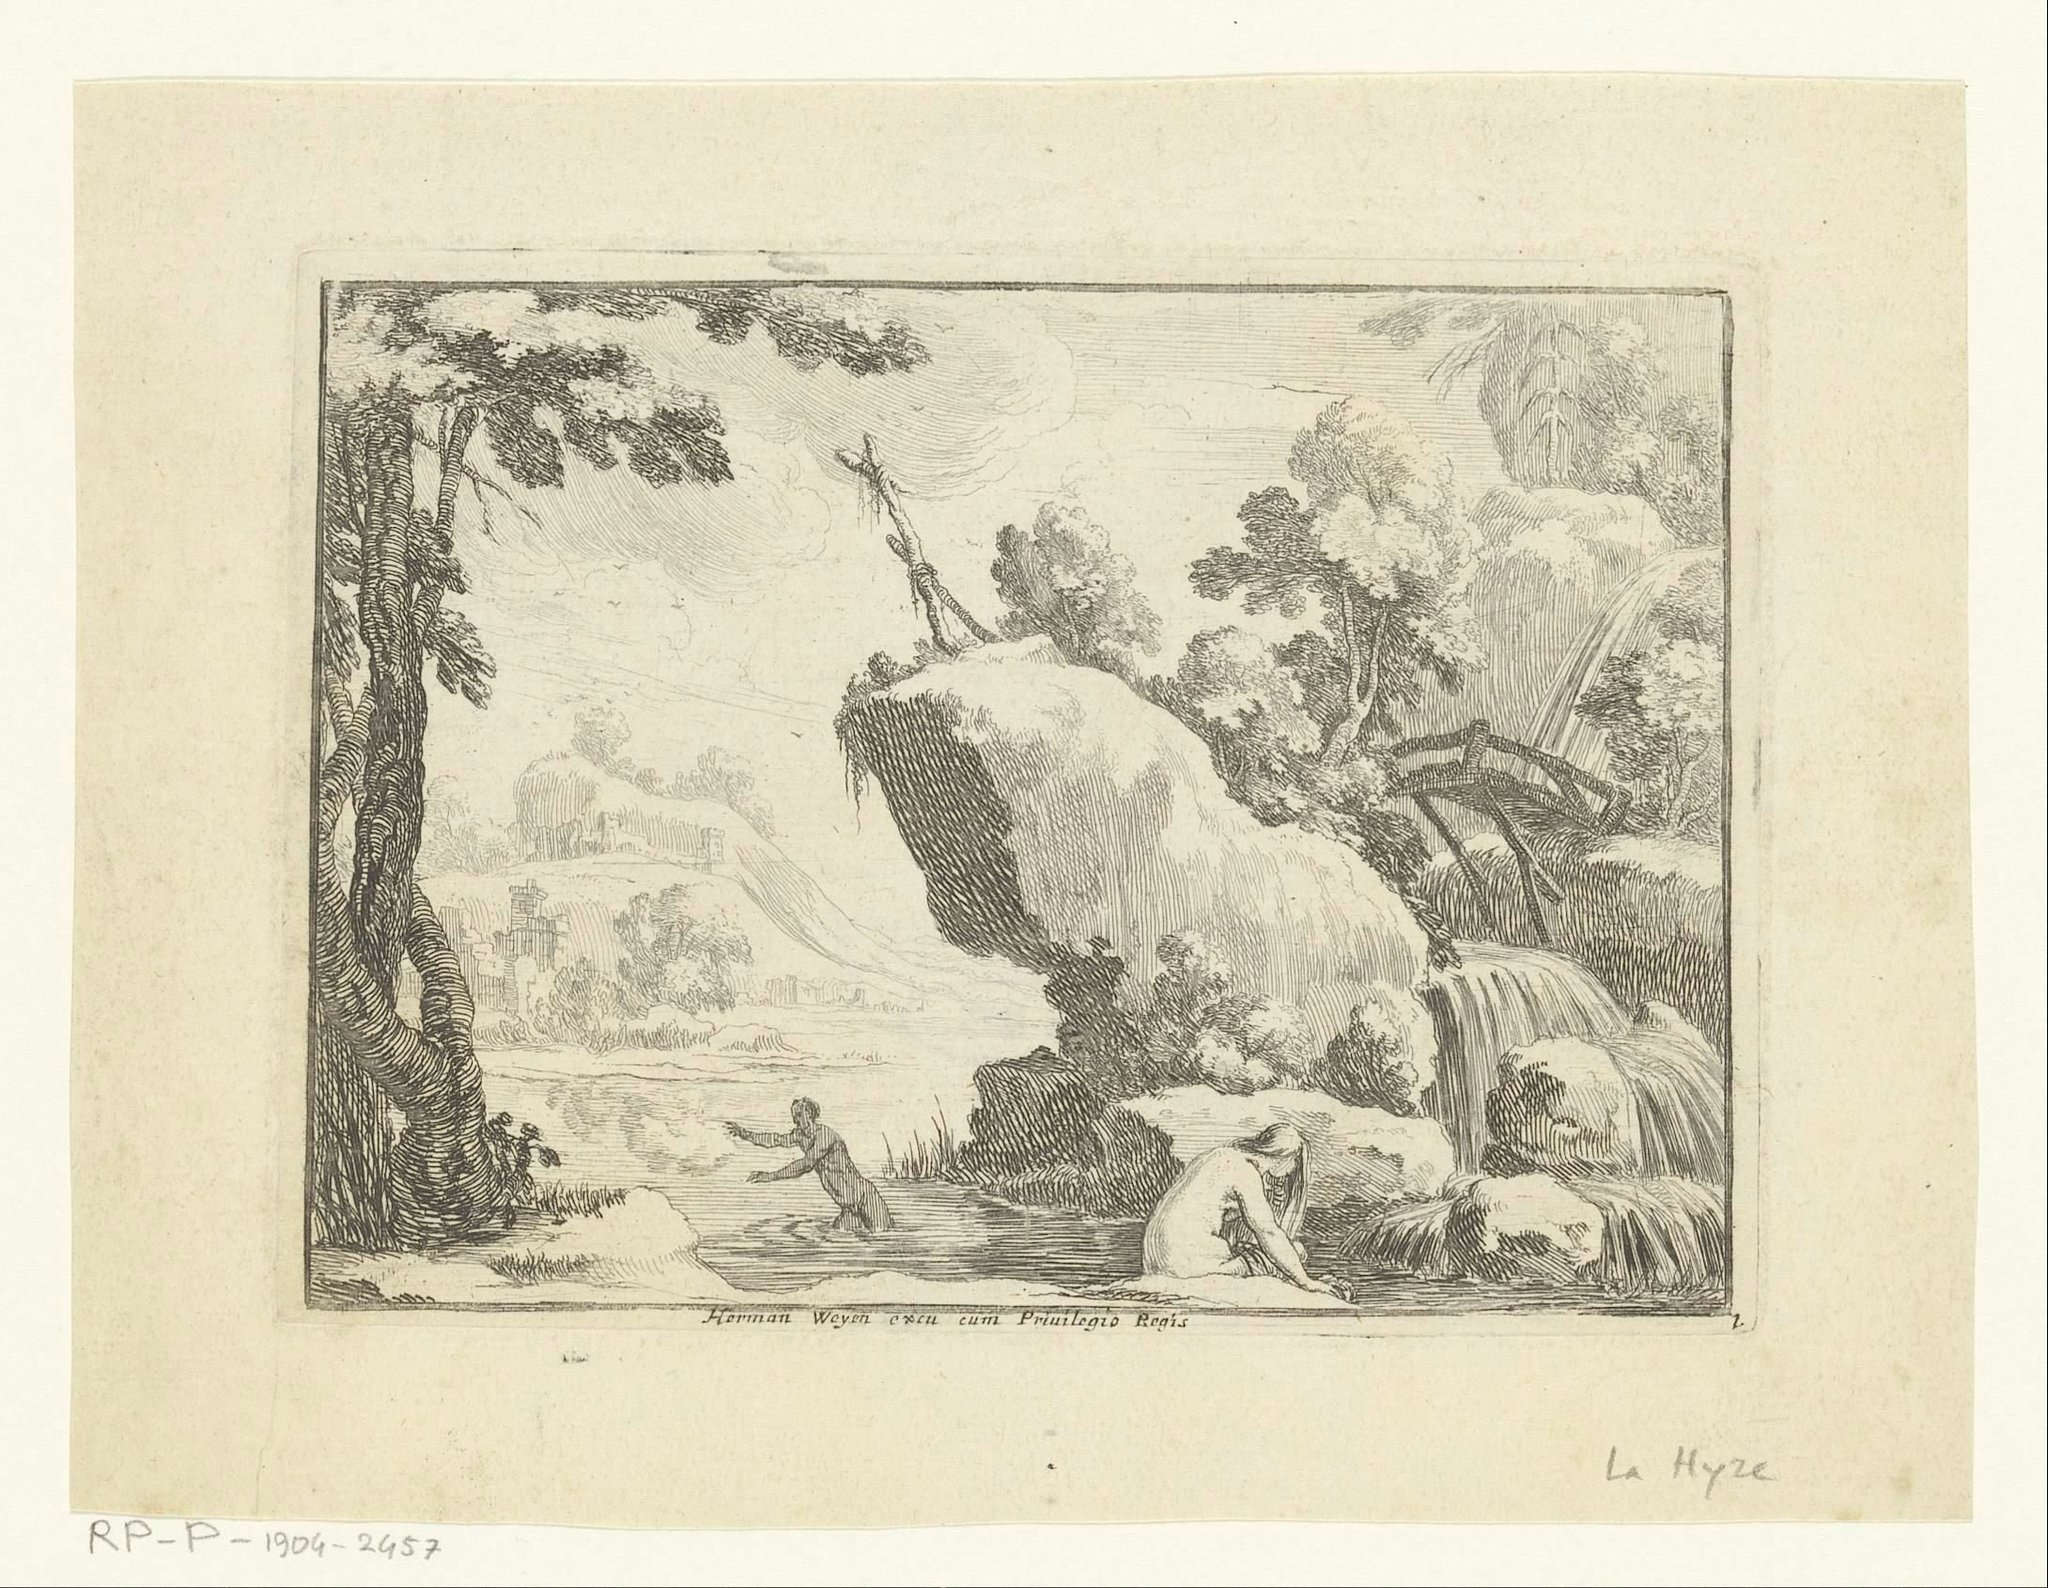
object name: print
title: Rotslandschap met waterval en badende figuren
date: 1616-1672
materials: paper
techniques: etching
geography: france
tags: waterfall, taking a bath - aa - in the open air, landscapes - hh - ideal landscapes (+ landscape with figures, staffage)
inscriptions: collector's mark: Lugt 2228